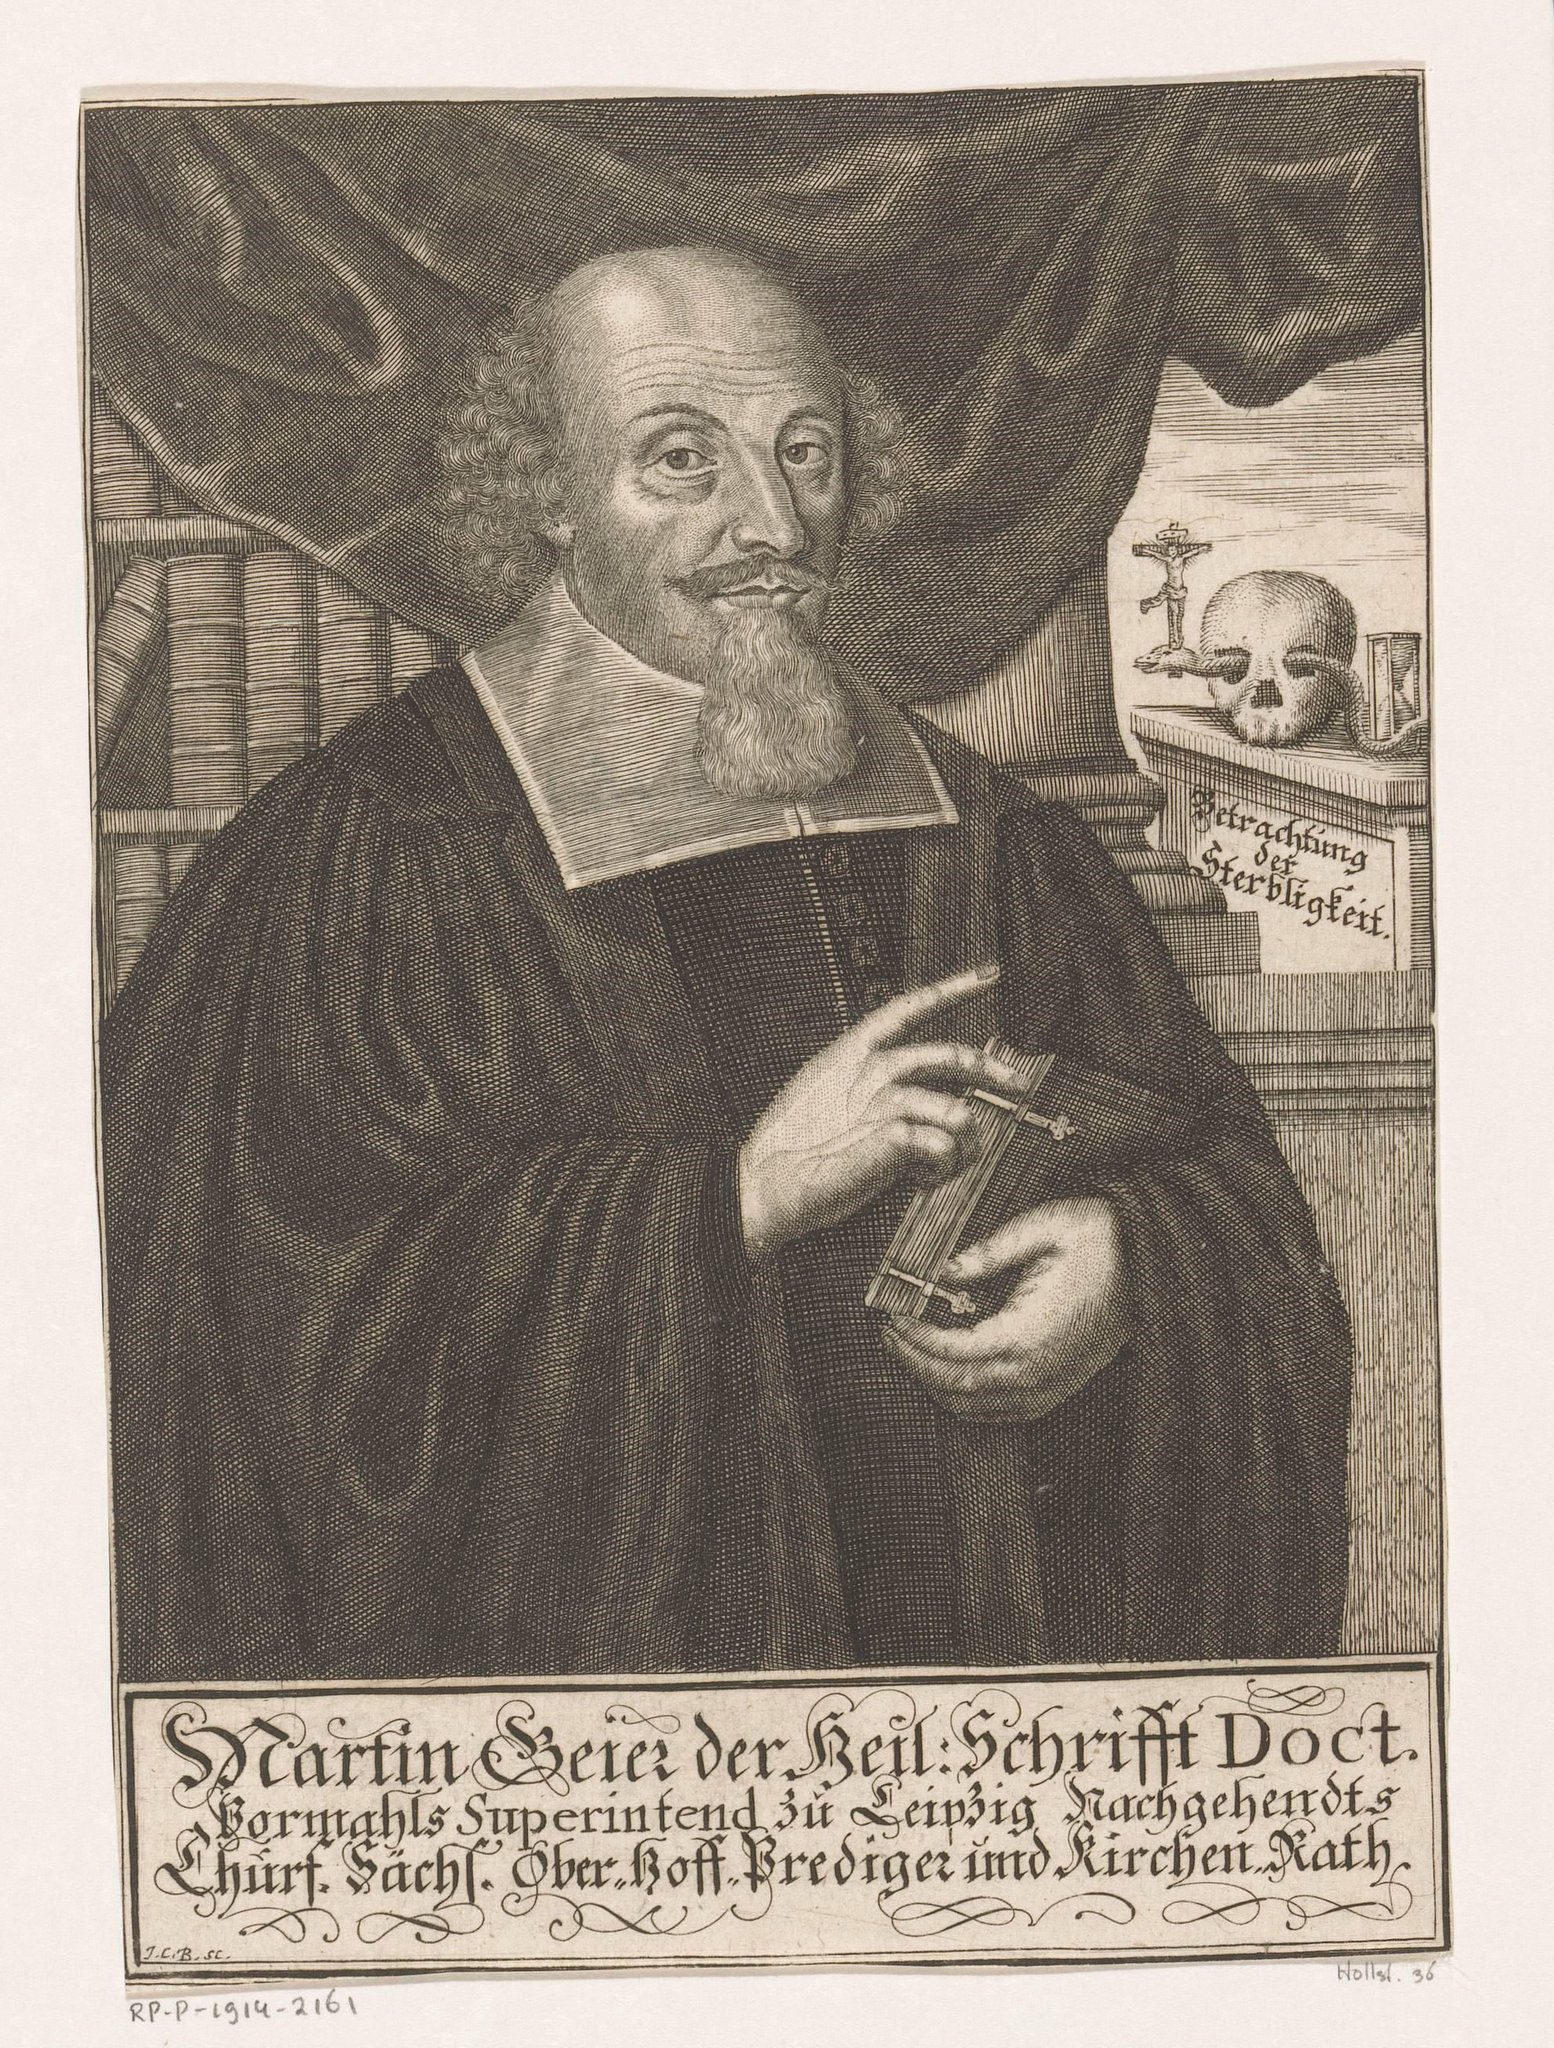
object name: print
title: Portret van Martin Geier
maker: johann christoph boecklin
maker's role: print maker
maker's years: 1657-1709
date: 1667-1709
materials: paper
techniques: engraving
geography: leipzig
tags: snakes, bookshelves, historical persons, book, hourglass, death's head, skull (symbol of death)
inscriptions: collector's mark: Lugt 2228